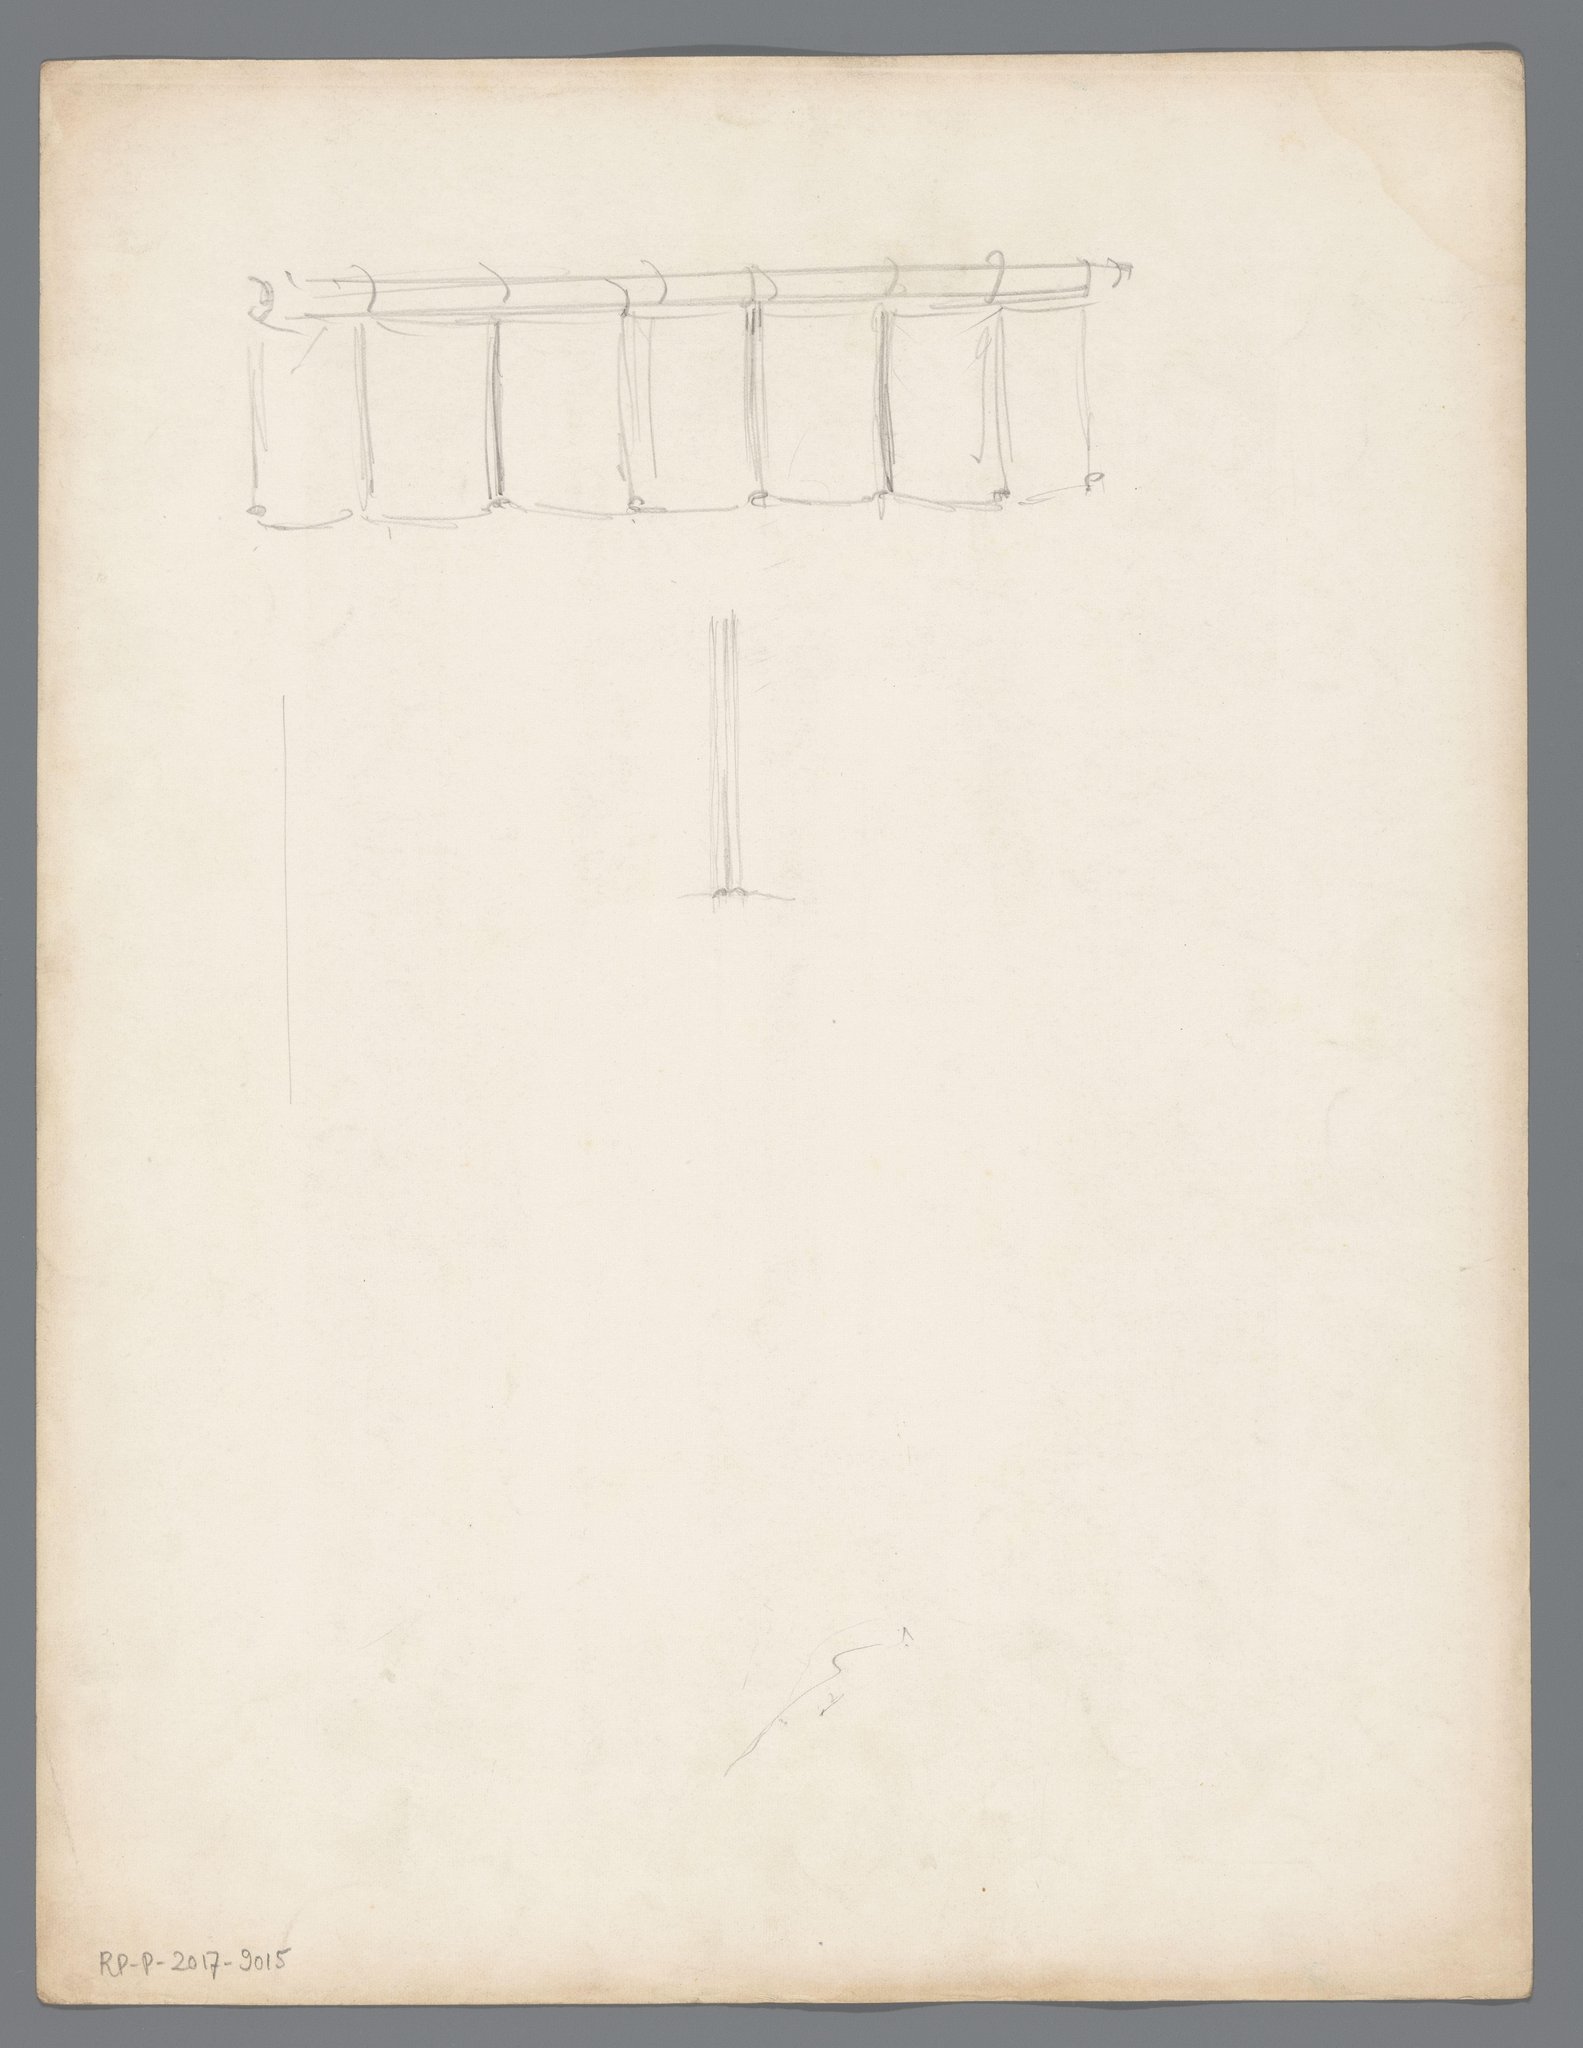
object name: drawing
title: Gordijn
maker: Anonymous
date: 1886-1899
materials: paper, pencil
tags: hangings and drapery